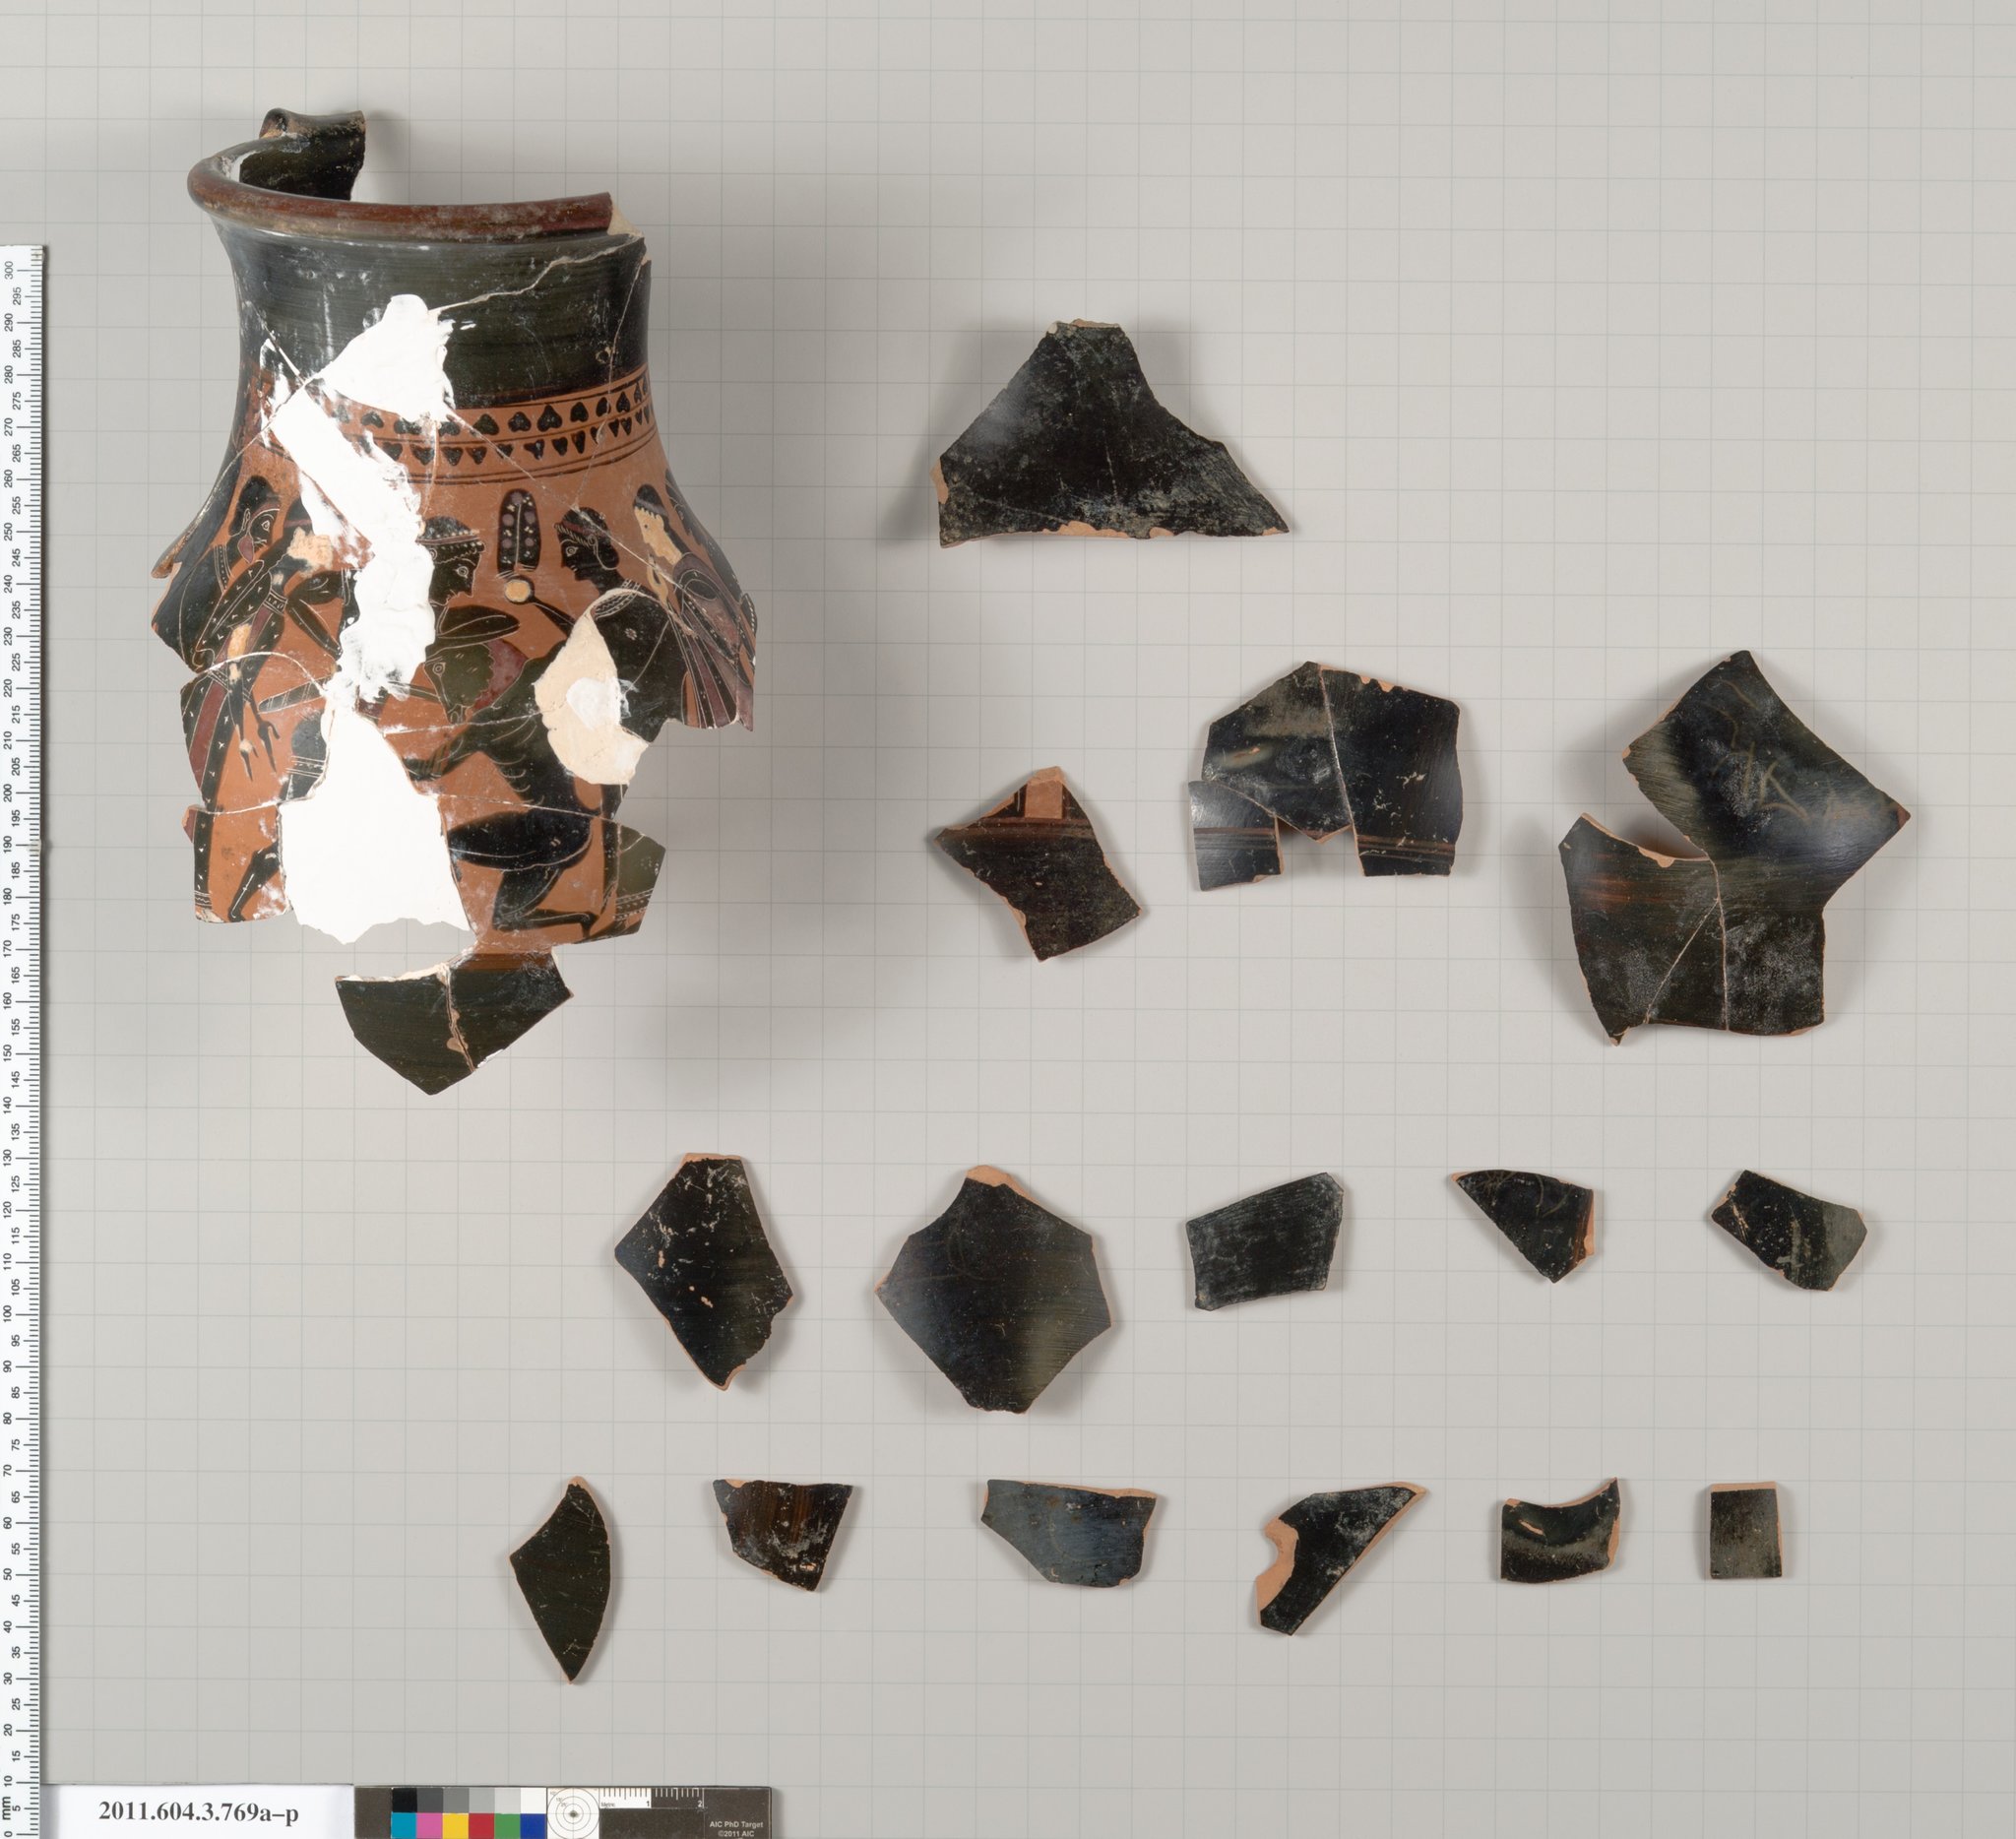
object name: olpe fragment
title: Terracotta fragments of an oinochoe: olpe (jug)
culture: greek, attic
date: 550-526 BCE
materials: terracotta